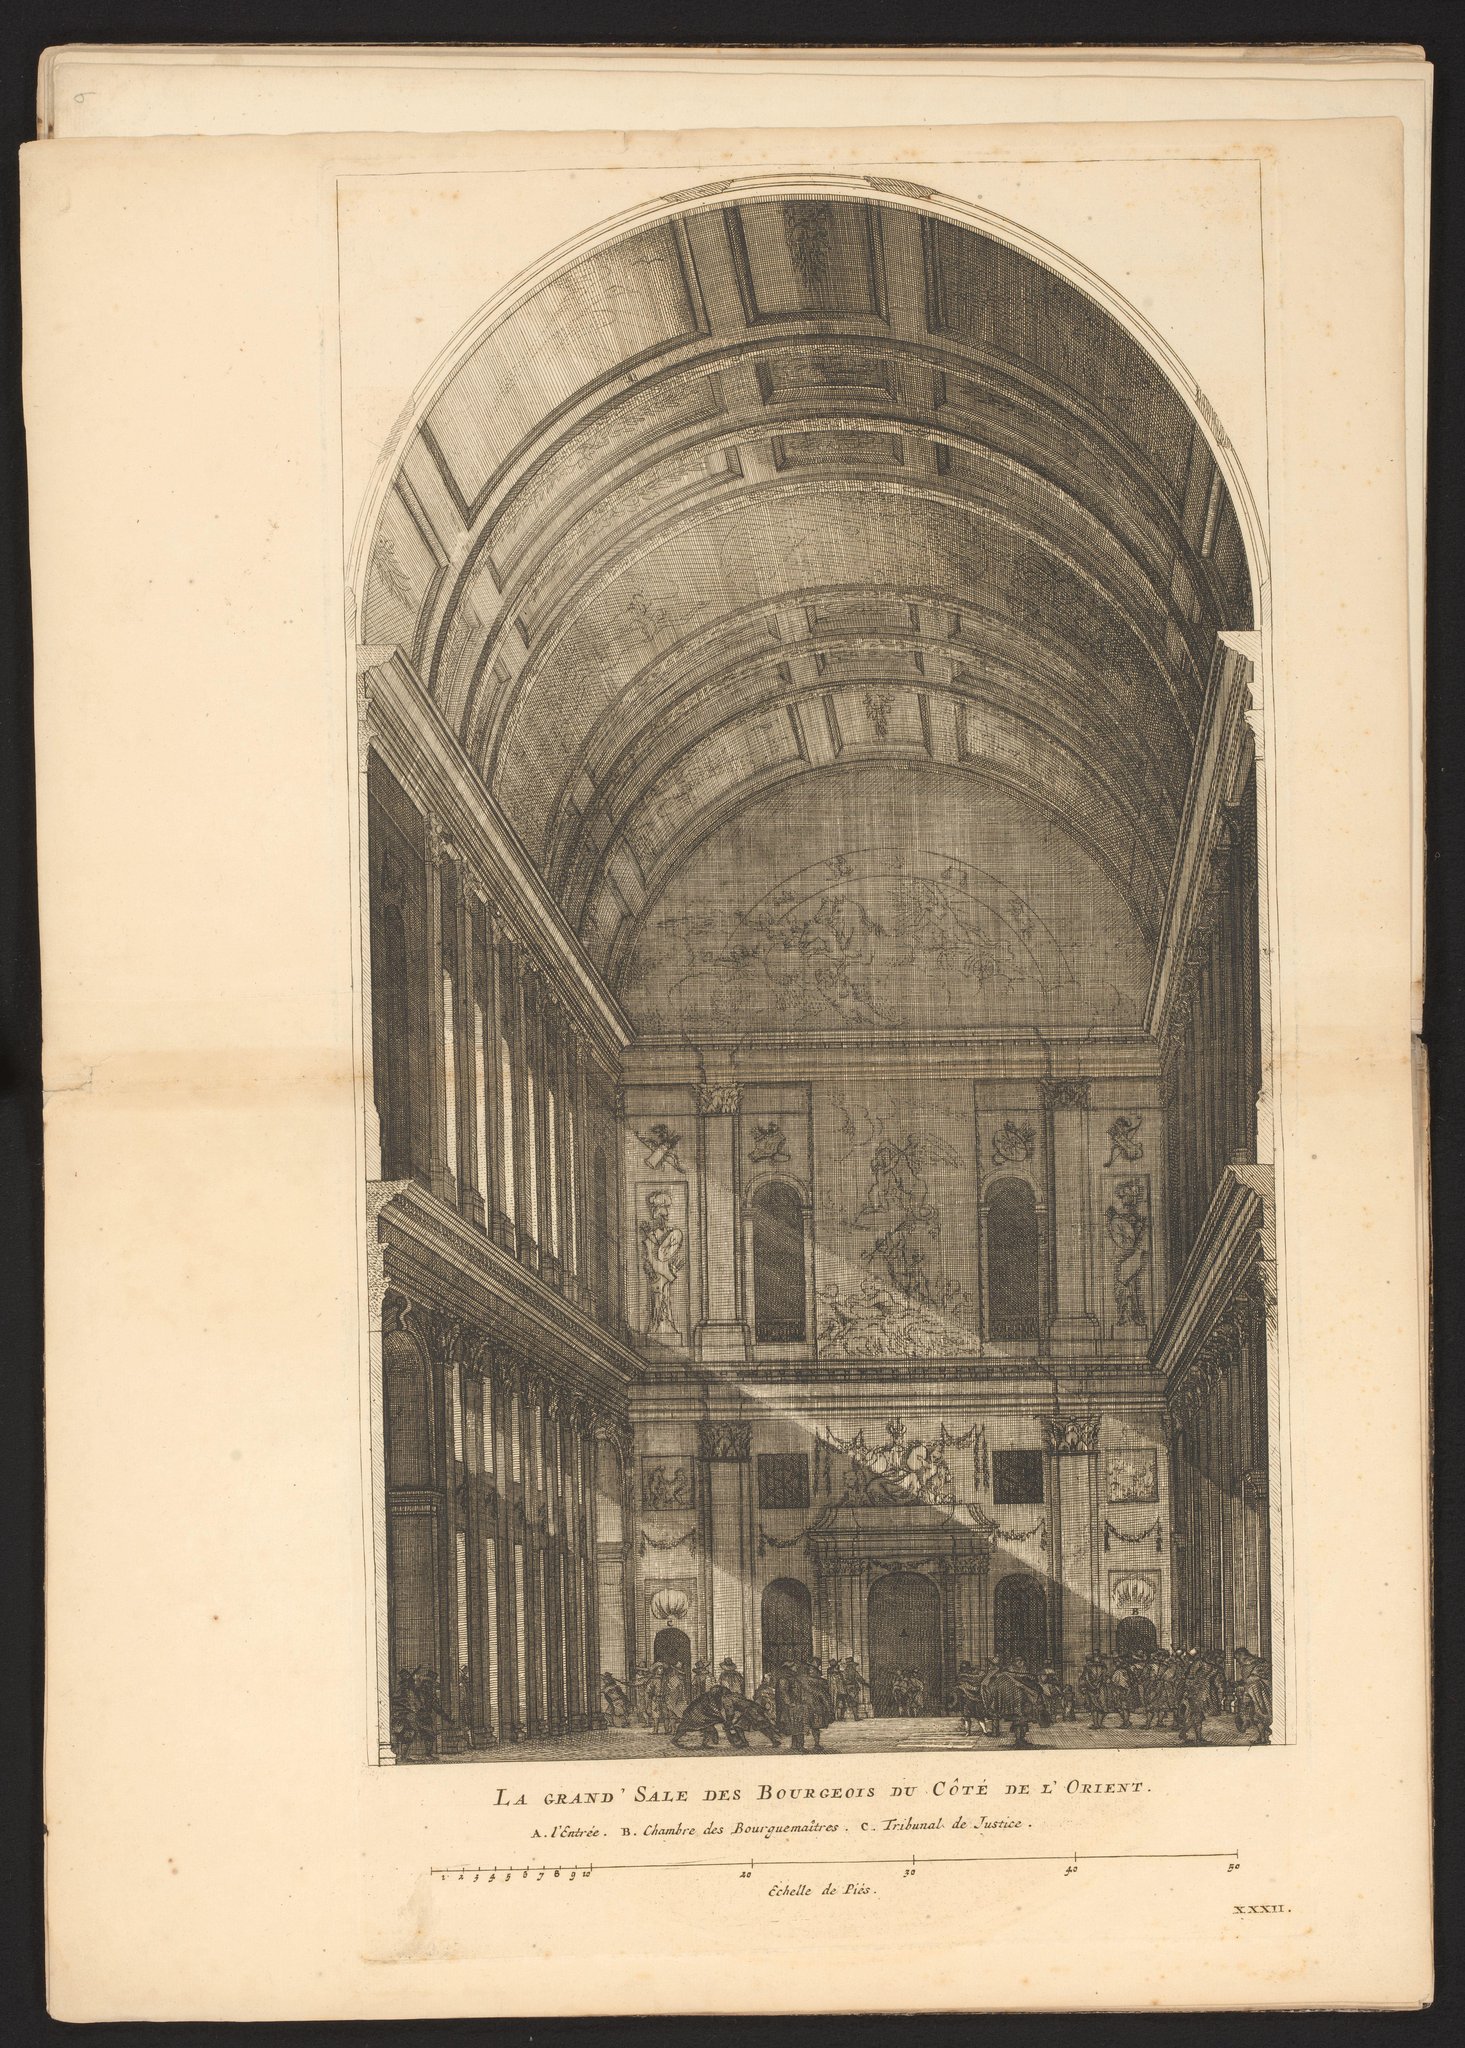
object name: book illustration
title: La Grand' Sale des Bourgeois du côté de l'Orient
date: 1719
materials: paper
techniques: engraving, etching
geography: amsterdam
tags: interior ~ architectural design or model, townhall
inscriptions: collector's mark: ‘Instituut voor kunst-nijverheidsonderwijs Gabriël Metsustraat No. 16 Amsterdam’, collector's mark: ‘Kunstnijverheidschool Quellinus Amsterdam Frans Halsstraat 14’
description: Prent waarschijnlijk uit: Architecture peinture et sculpture de la Maison de Ville d'Amsterdam, representee en CIX. figures en taille-douce (…). Amsterdam: David Mortier, 1719. Of uit de uitgave van dit werk door Gerard Valck uit 1719, of uit: Bouw schilder en beeldhouwkonst, van het Stadhuis te Amsteldam, vertoont in CIX figuuren (…). Amsterdam: Covens & Mortier & Covens Jr., s.a. (1774-1783). Prent werd in een eerdere staat gebruikt in: Afbeelding van 't stadt huys van Amsterdam, In dartigh Coopere Plaaten, geordineert door Jacob van Campen; en Geteeckent door Iacob Vennekool. Amsterdam: Dancker Danckerts, 1661. En in de editie van dit werk uitgegeven door Frederik de Wit, s.a. [1666-1706].